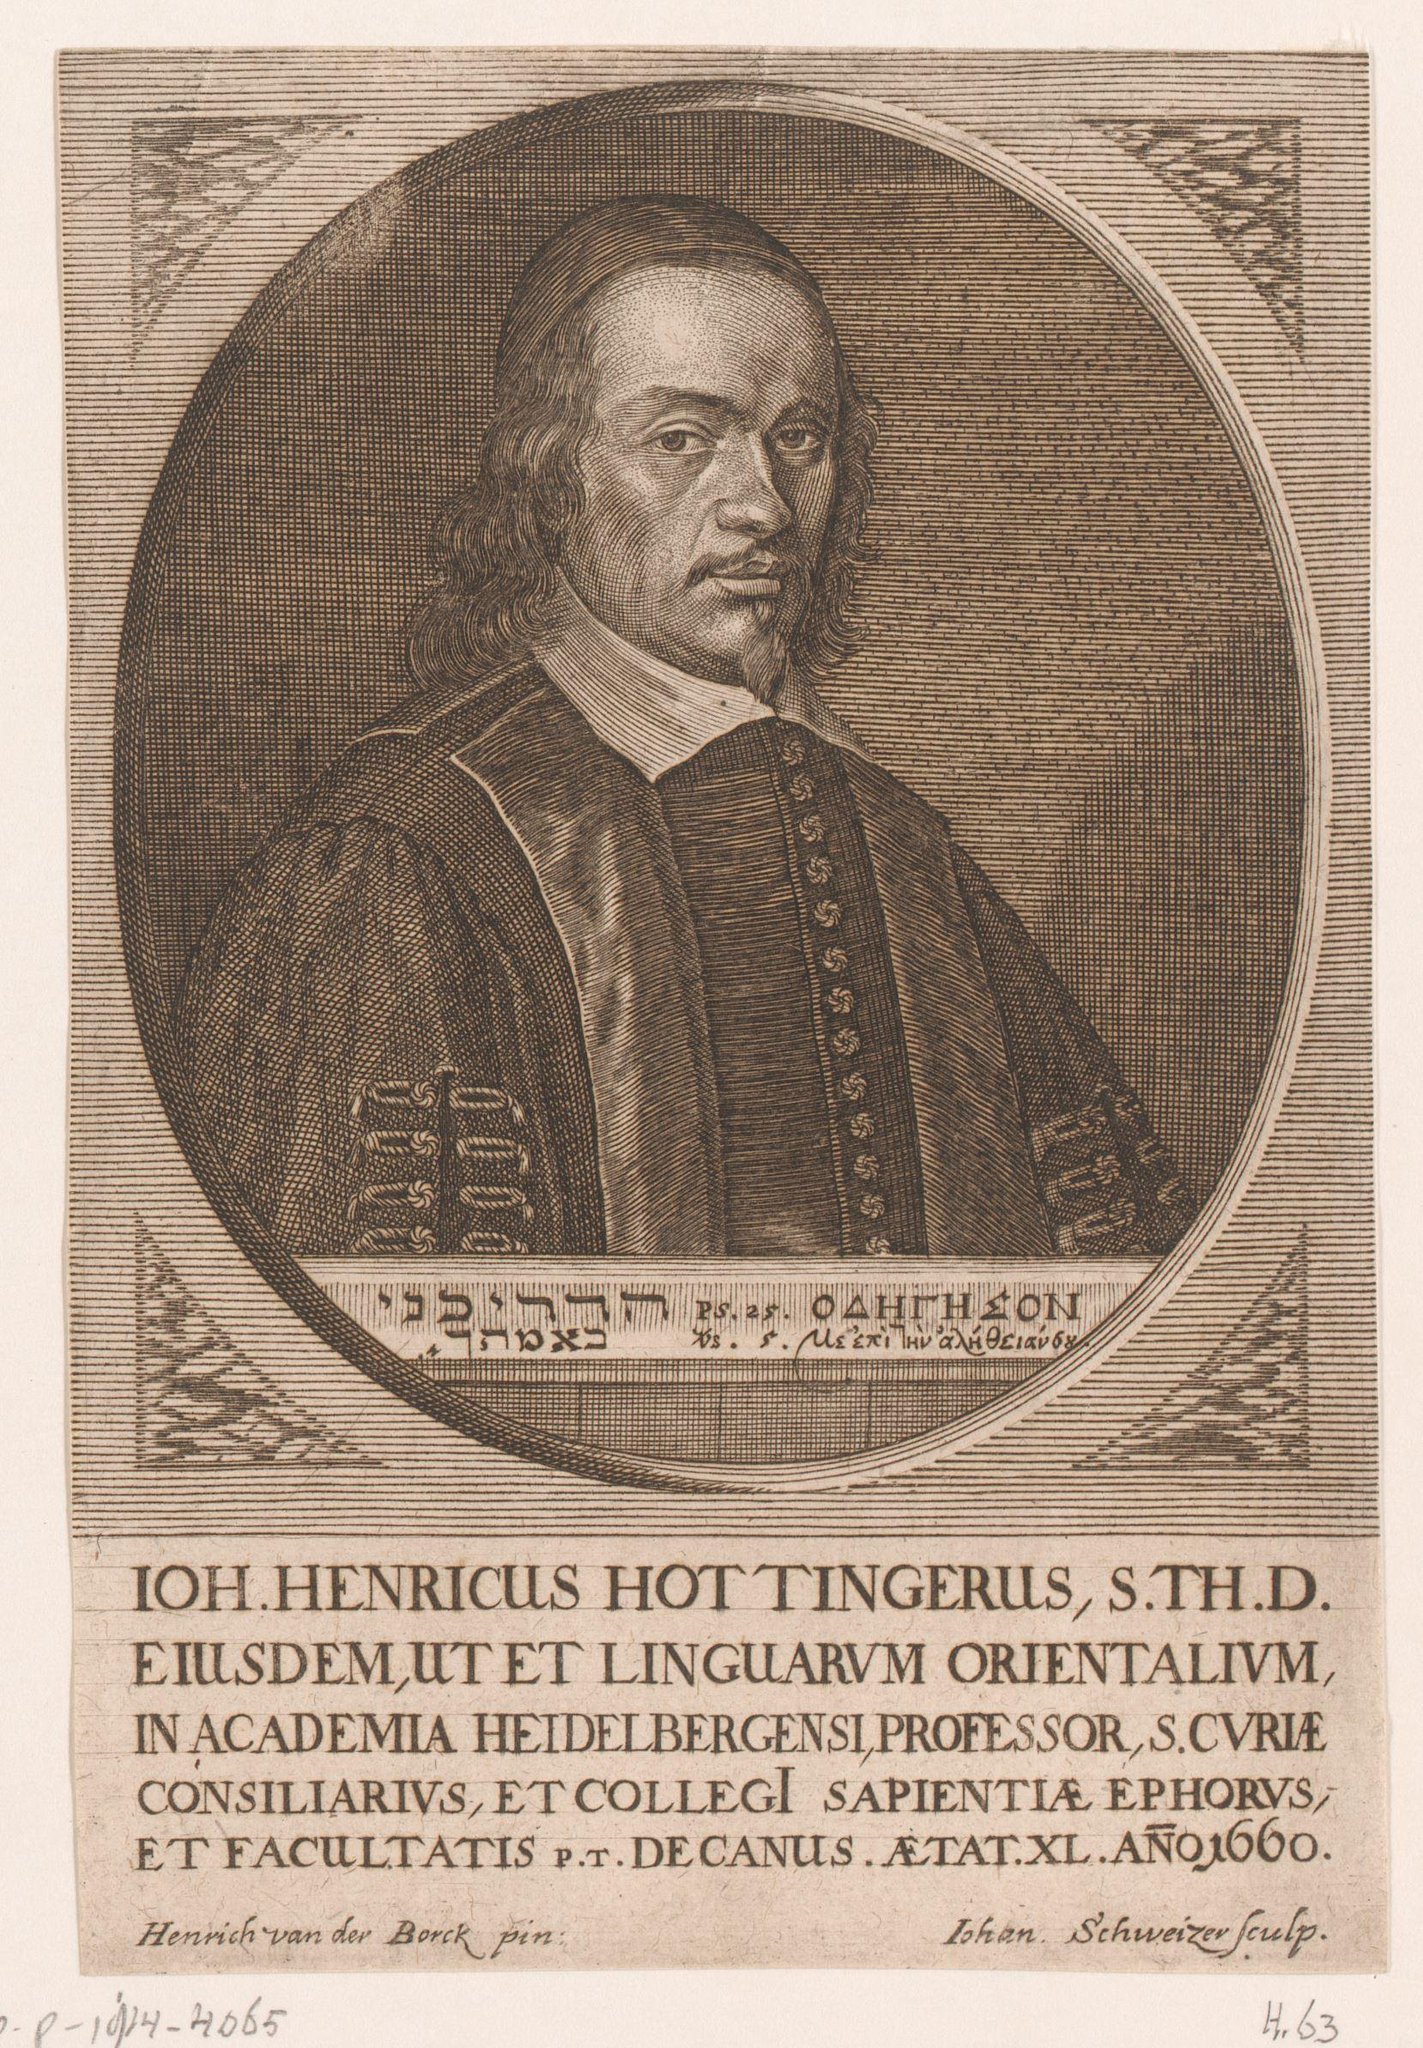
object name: print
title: Portret van Johann Heinrich Hottinger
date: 1660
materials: paper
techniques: engraving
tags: historical persons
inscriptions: collector's mark: Lugt 2228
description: Prent ook gebruikt in: Berger, Hieronymus. Parnassus Heidelbergensis (...). Frankfurt am Main: Hieronymus Berger, 1660.